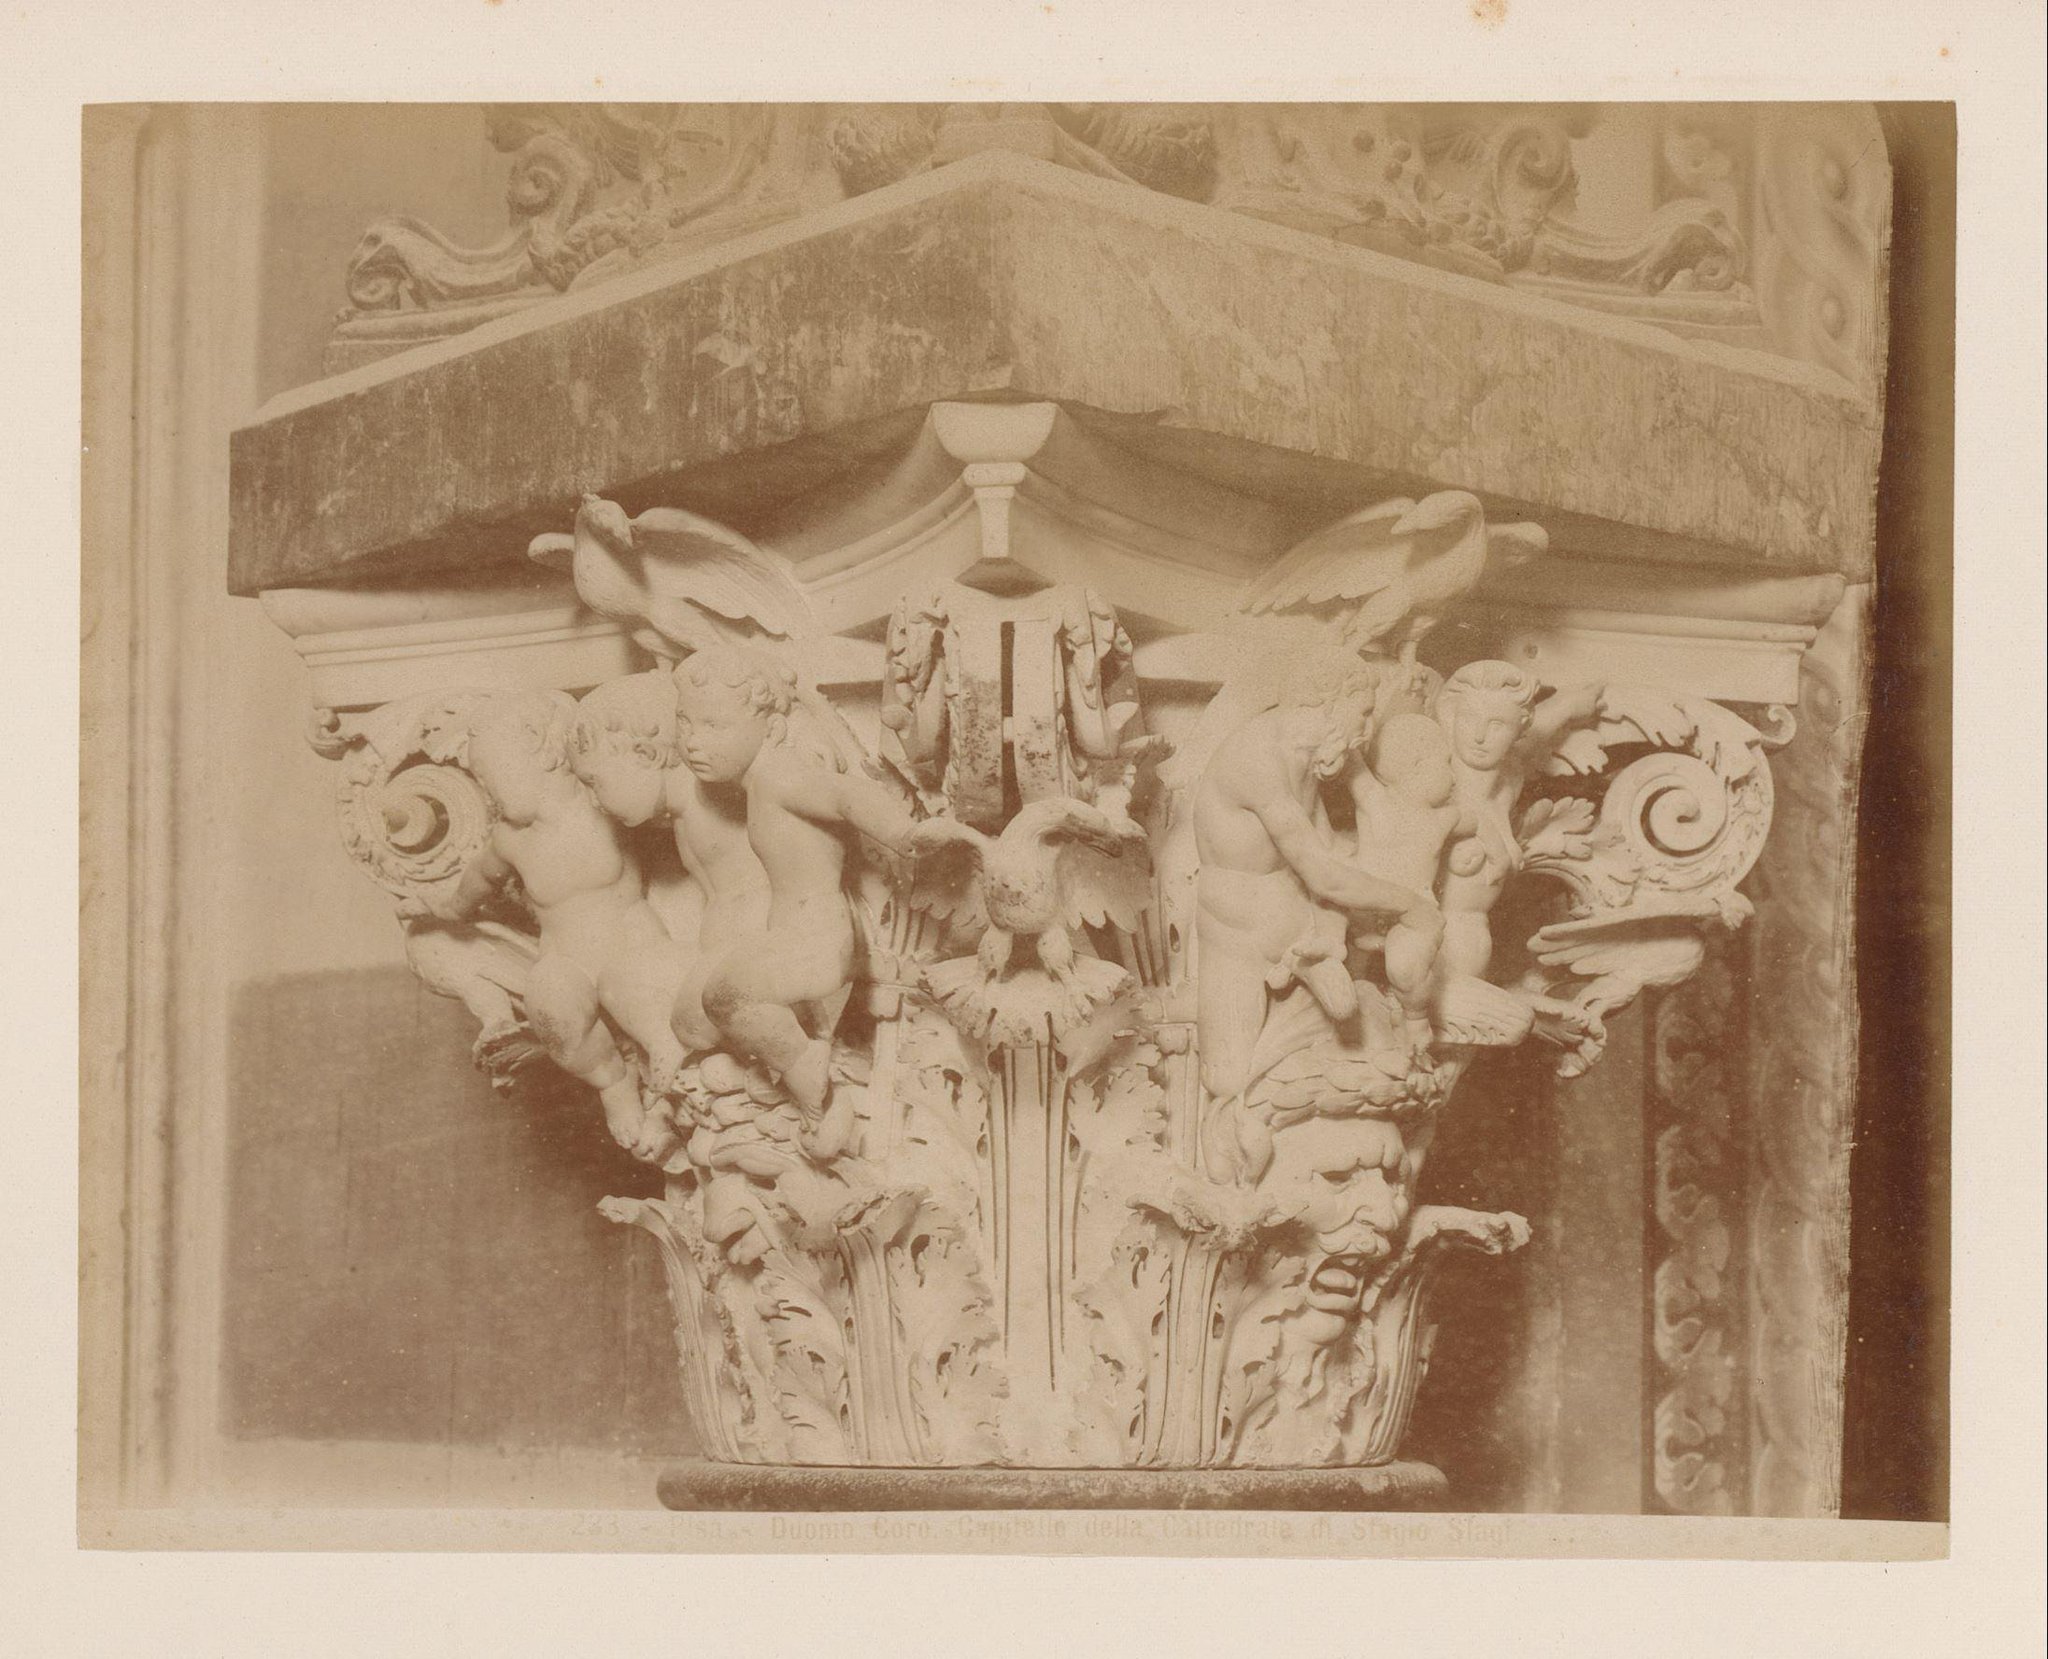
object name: album leaf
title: Corintisch kapiteel in de Dom te Pisa, Italië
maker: giacomo brogi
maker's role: fotograaf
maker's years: 1822-1881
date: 1860-1881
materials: paper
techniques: albumen print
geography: pisa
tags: capital (~ column, pillar)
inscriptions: number: ‘233’